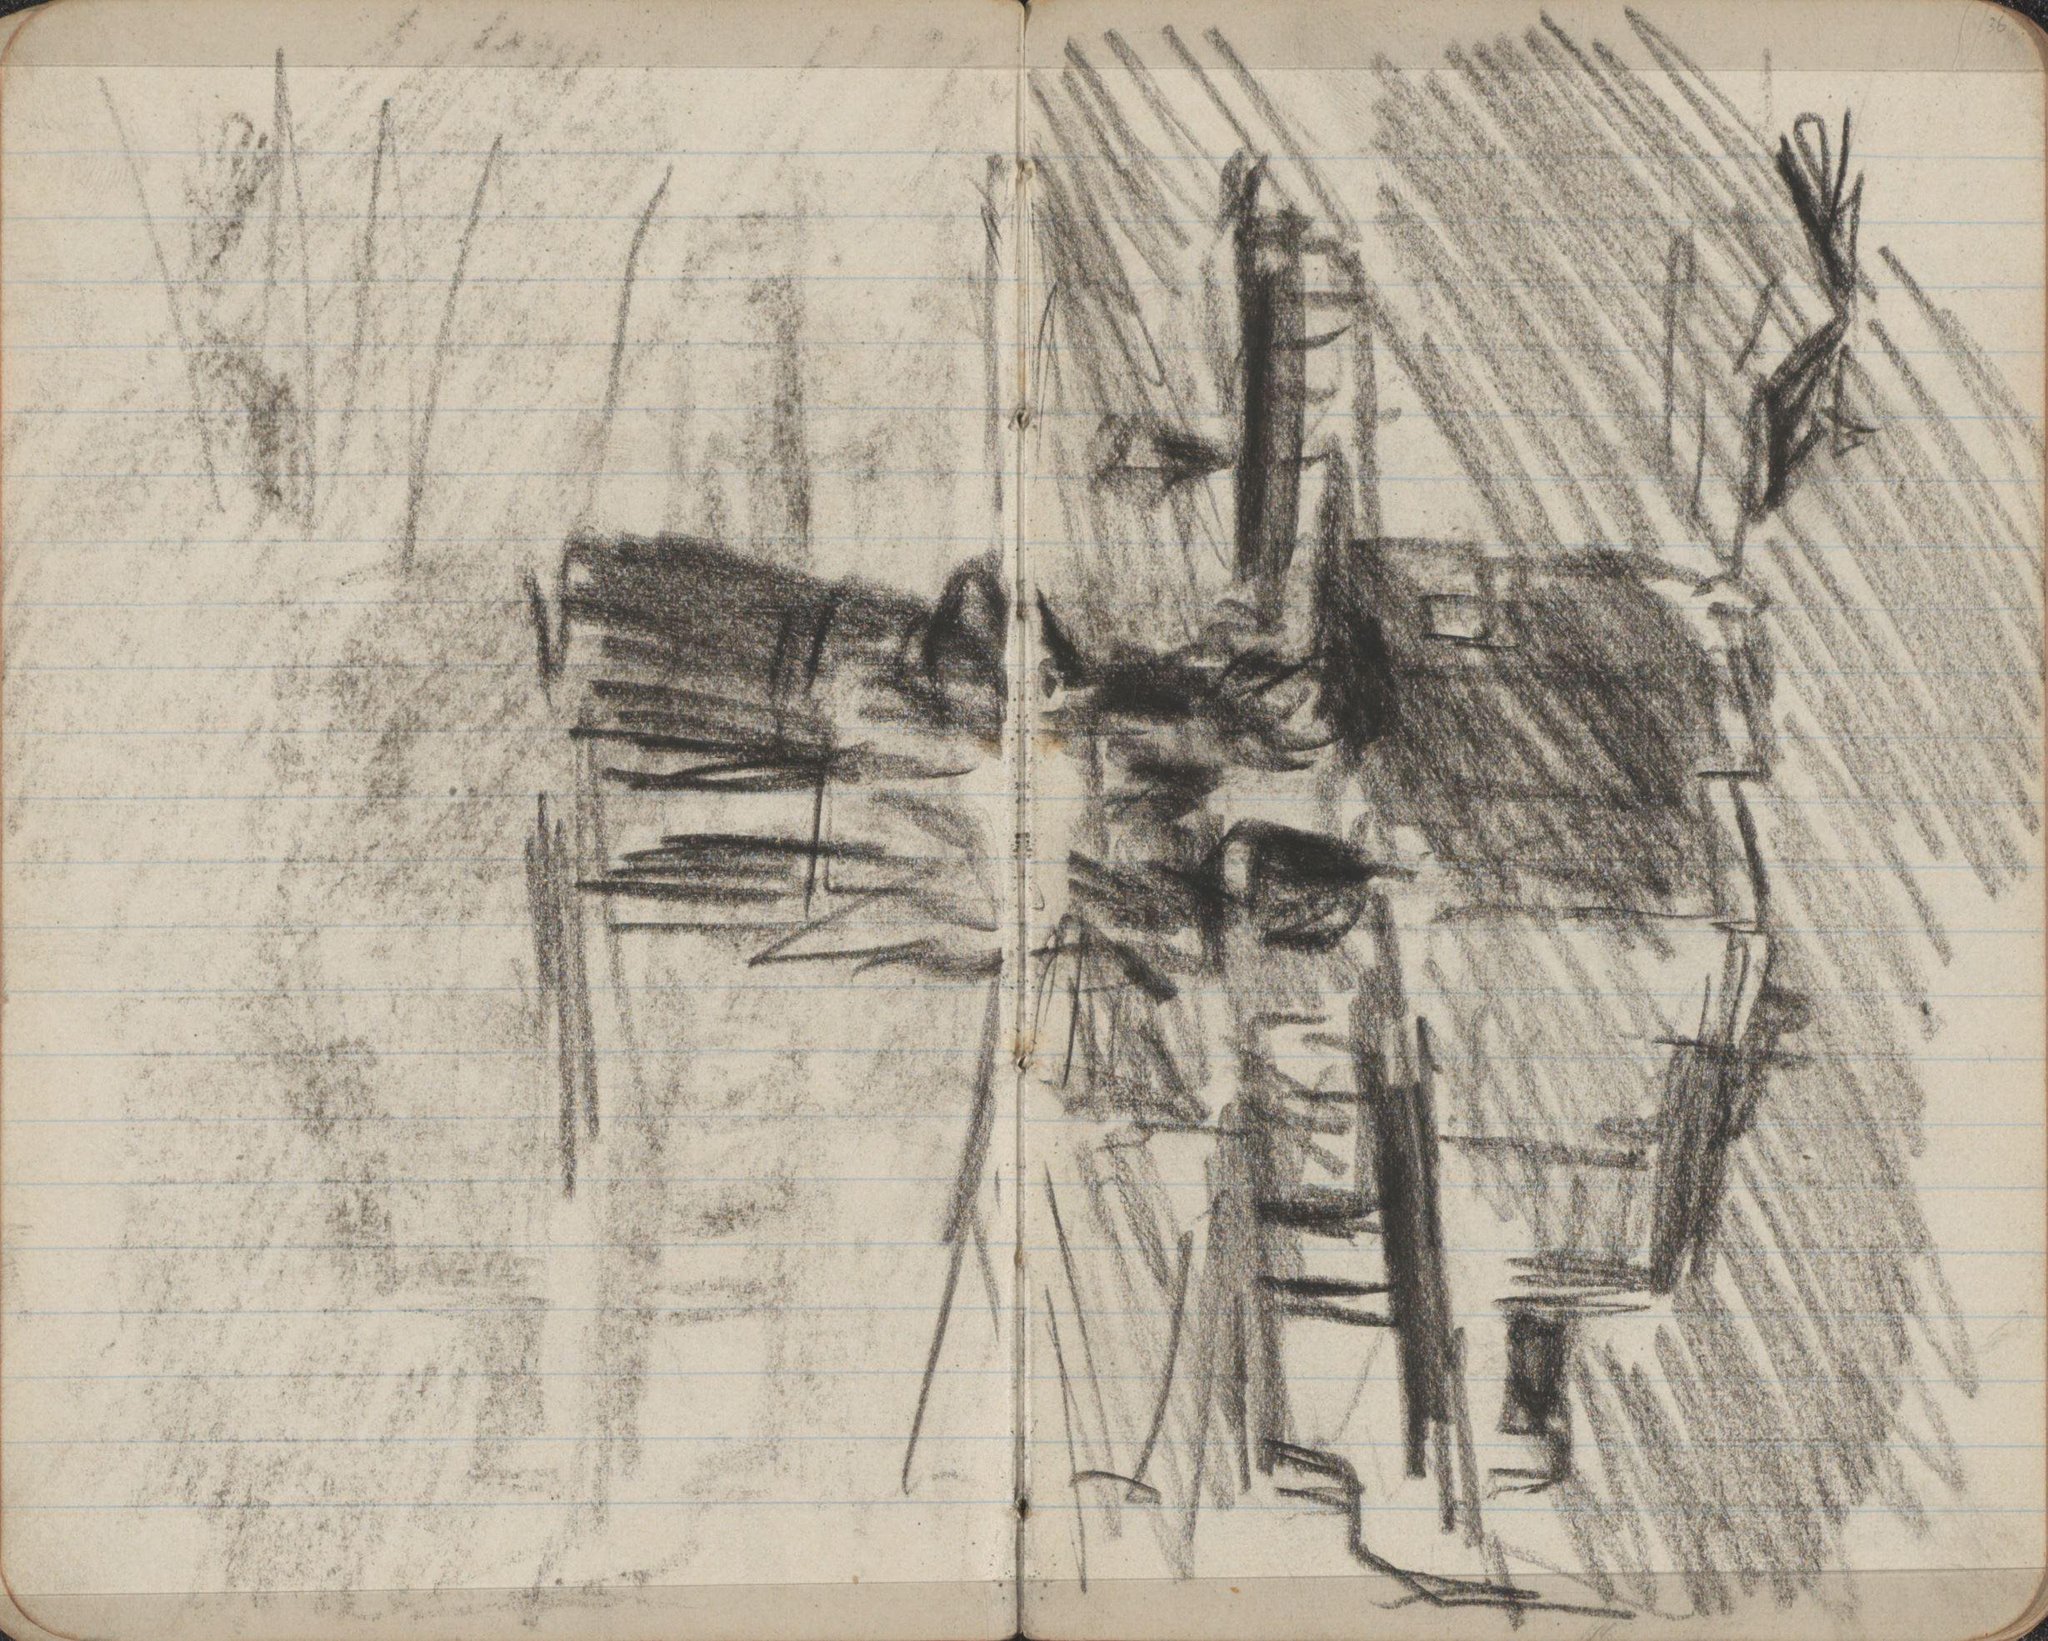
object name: sketchbook leaf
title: Vrouwen op de Dam te Amsterdam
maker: george hendrik breitner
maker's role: draughtsman, painter, print maker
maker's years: 1857-1923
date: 1893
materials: chalk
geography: amsterdam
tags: adult woman, civic architecture; edifices; dwellings, square, place, circus, etc. (+ city(-scape) with figures, staffage)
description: Pagina 35 en pagina 36 uit een schetsboek met 38 bladen.